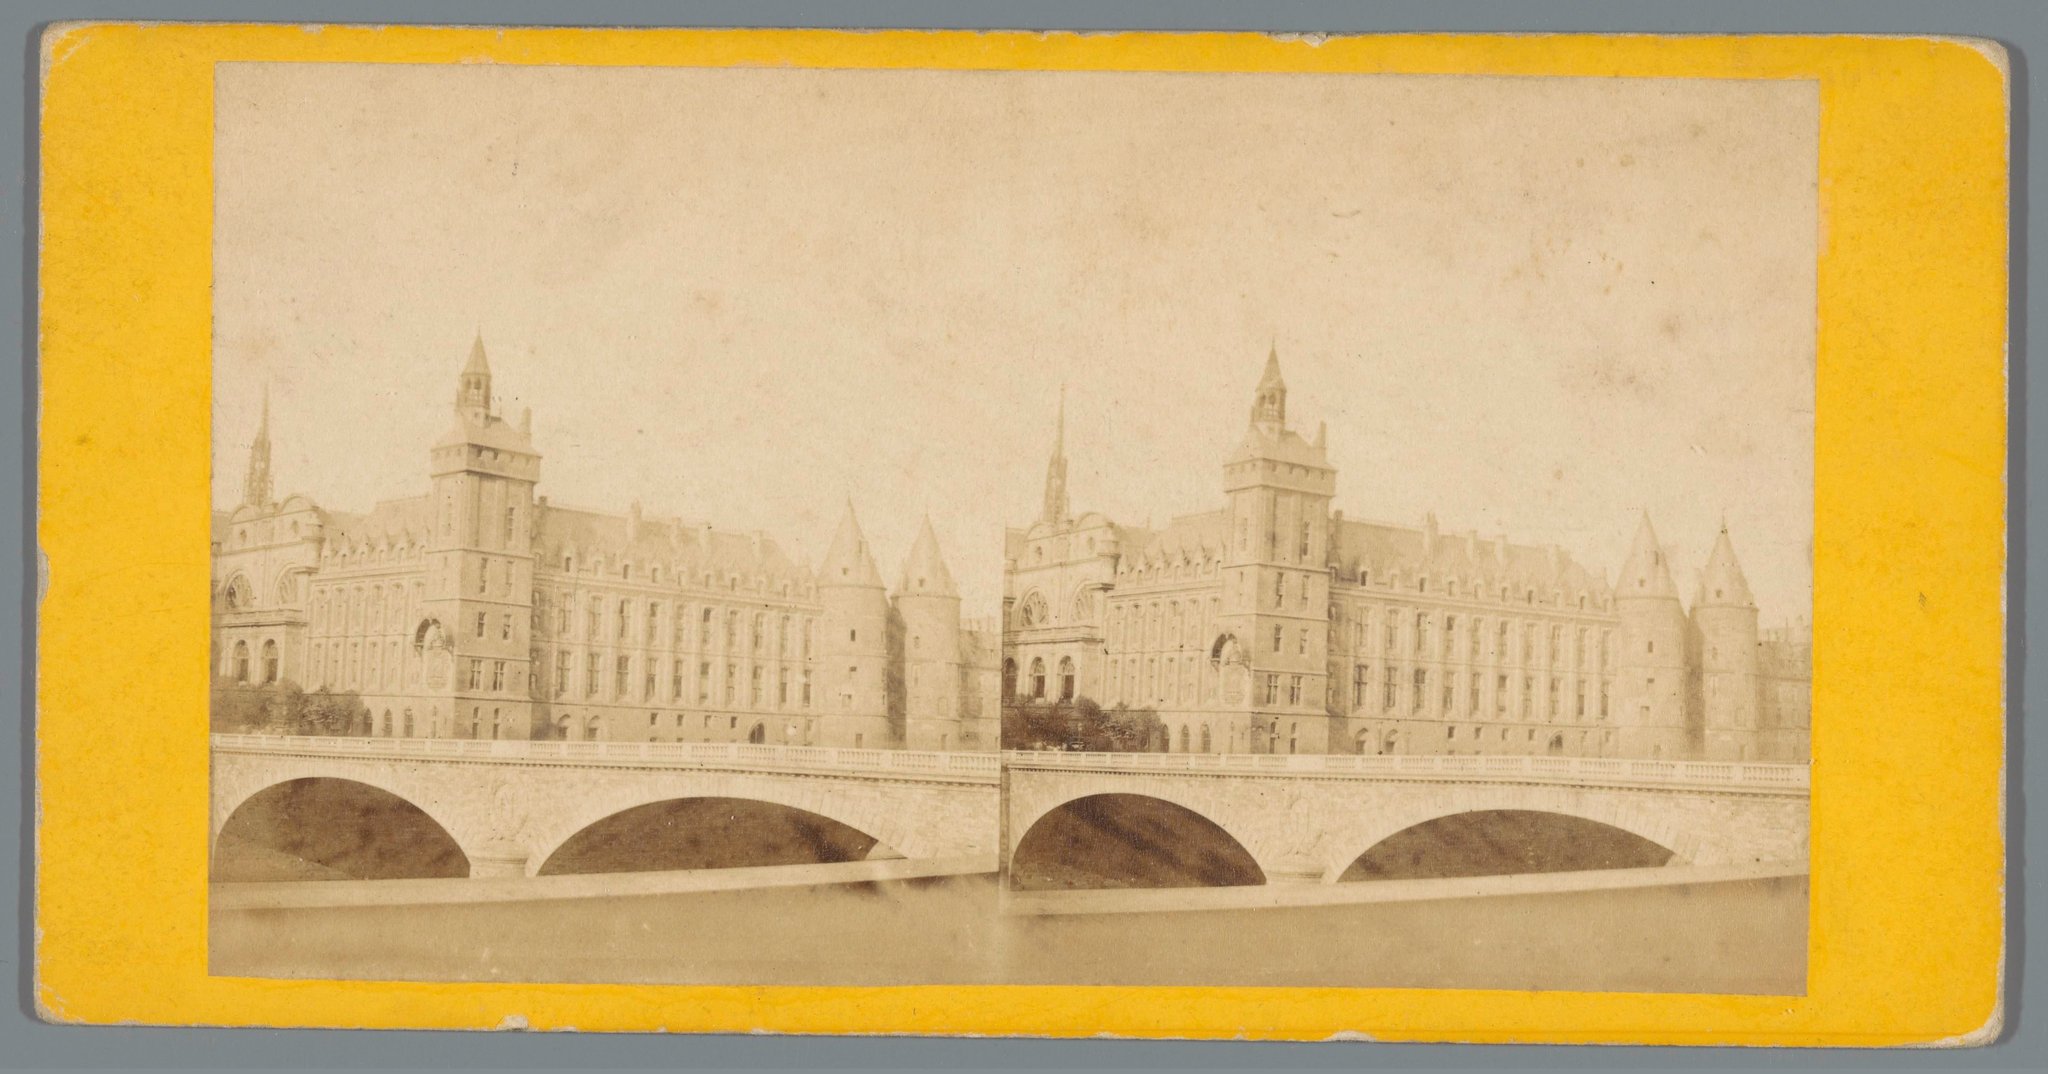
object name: stereograph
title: Gezicht op La Conciergerie en de Pont au Change in Parijs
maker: Anonymous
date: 1860-1880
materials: cardboard, photographic support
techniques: albumen print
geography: paris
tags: bridge in city across river, canal, etc.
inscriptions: inscription: ‘Palais de Justice Pont au Change [...]’